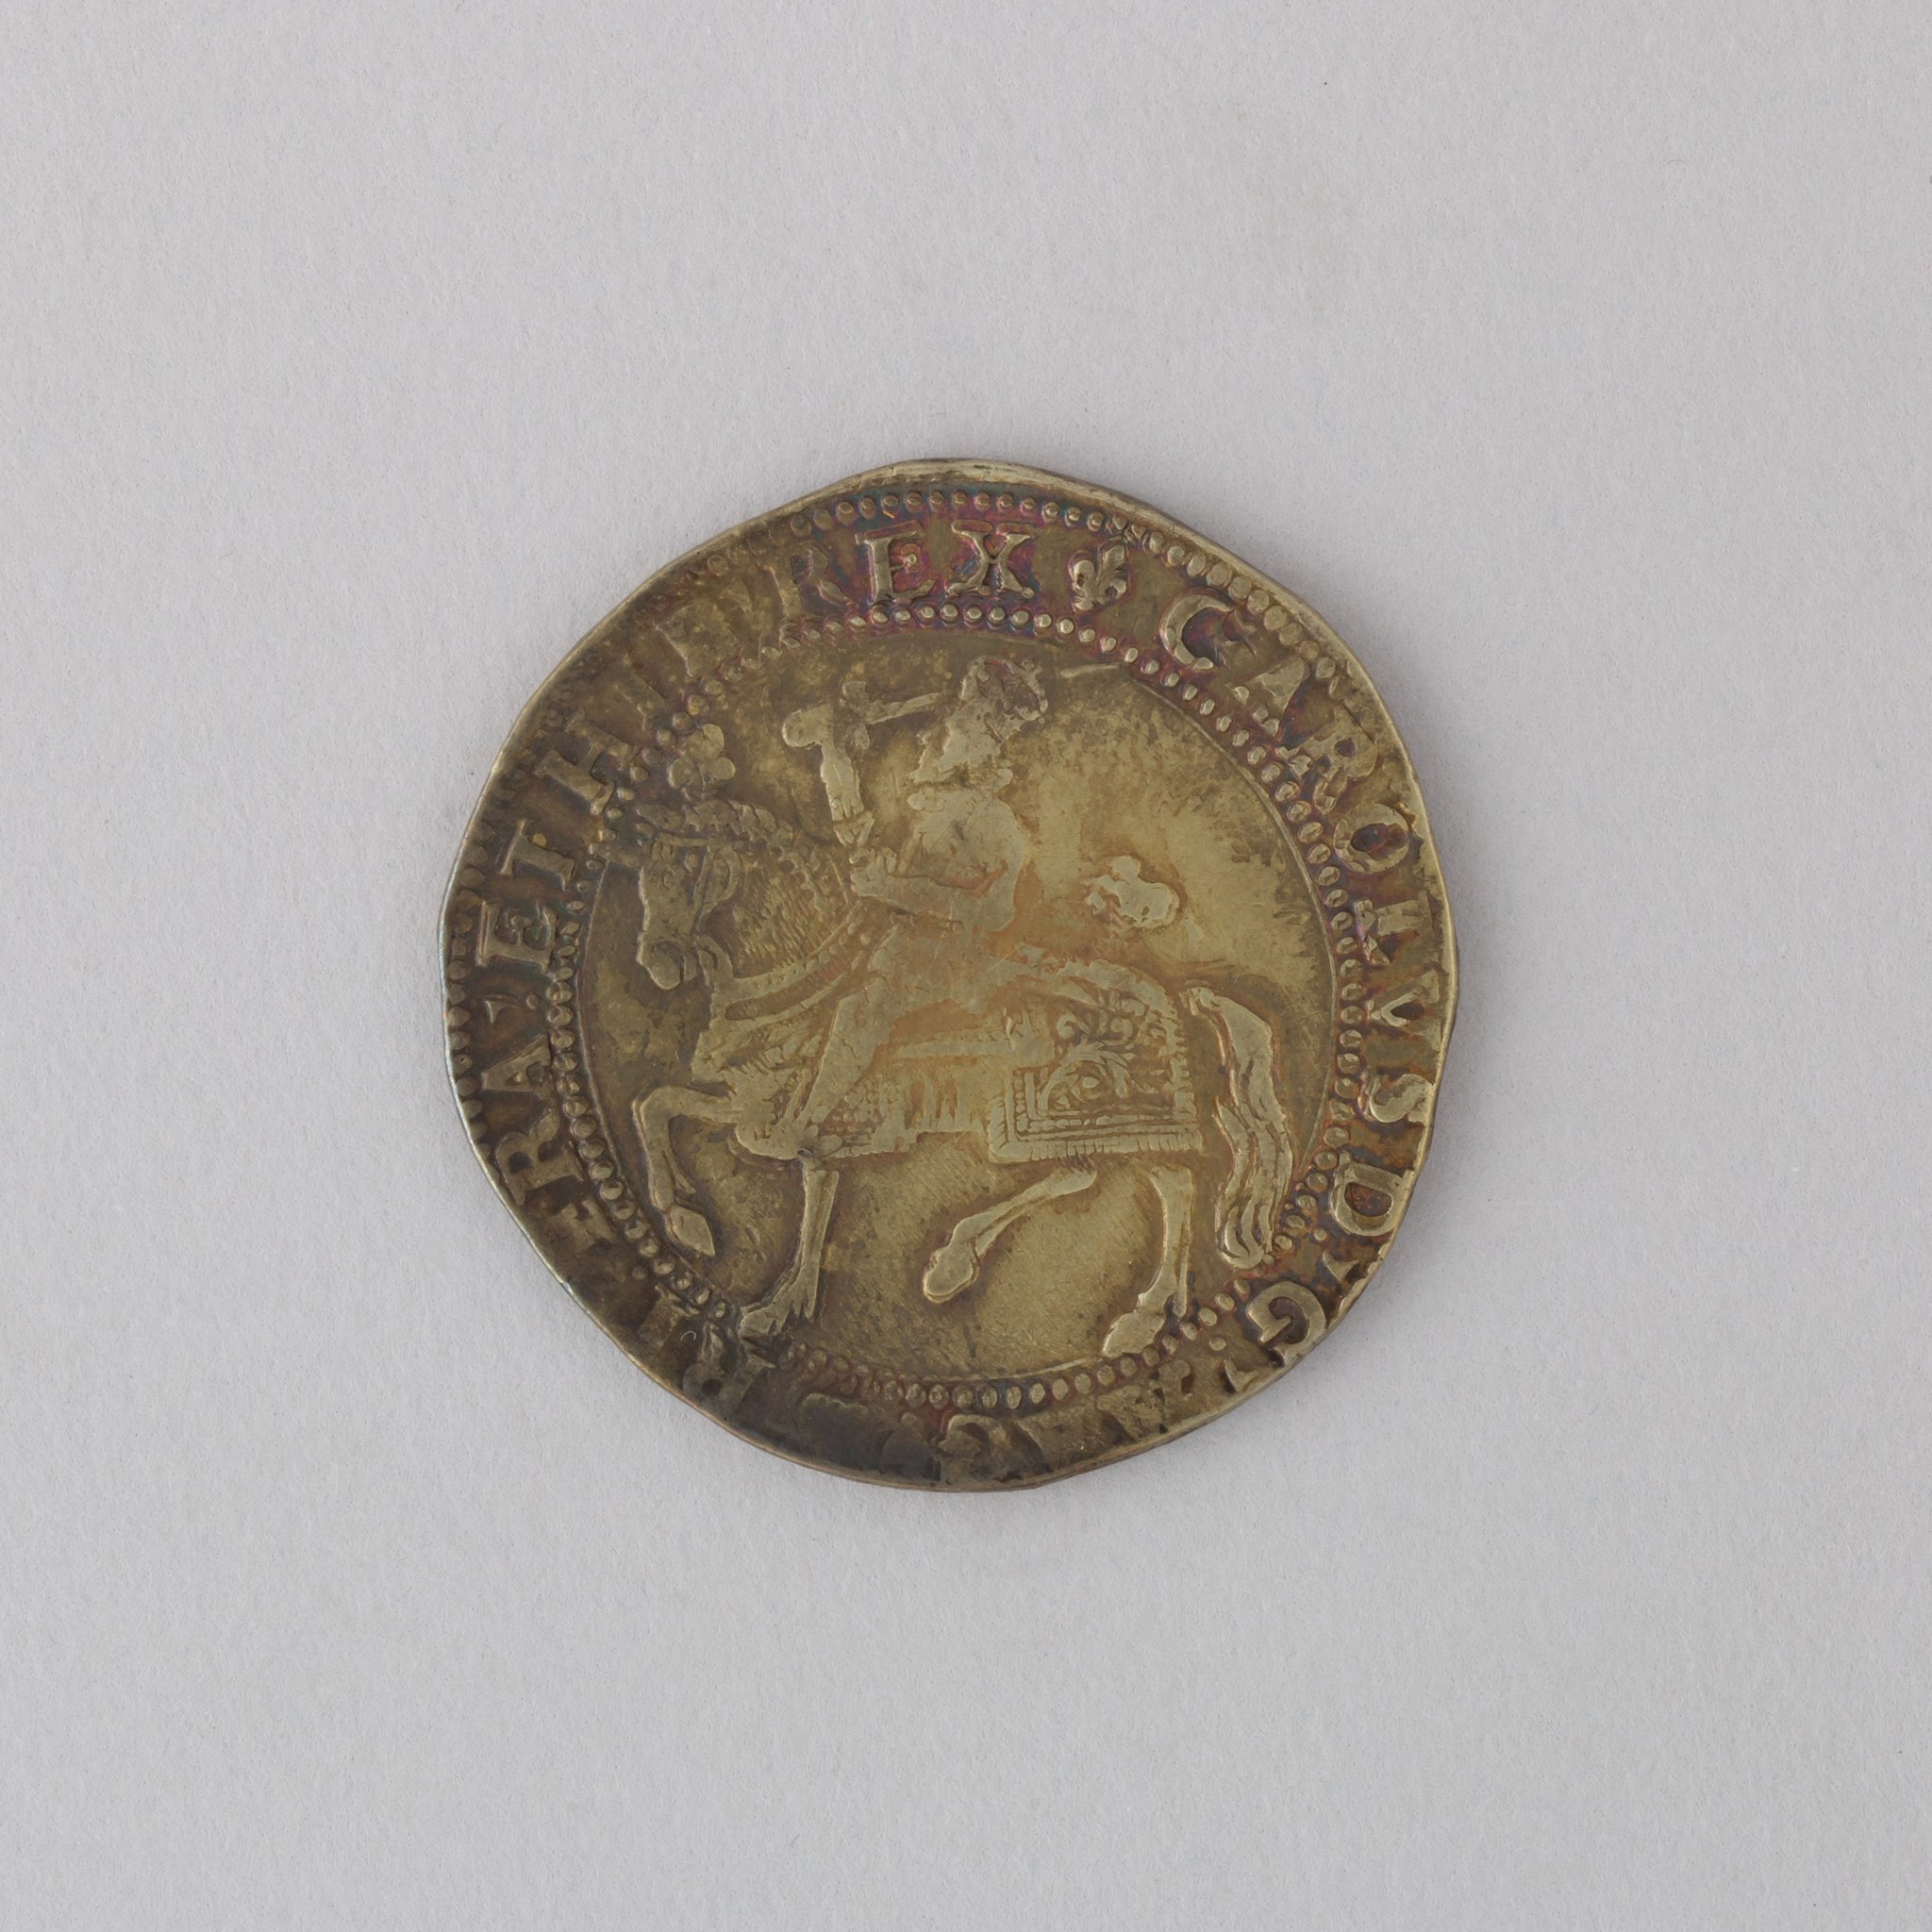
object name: crown coin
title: Coin (Crown) Showing Charles I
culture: british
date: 1625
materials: gold, silver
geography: england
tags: men,horses